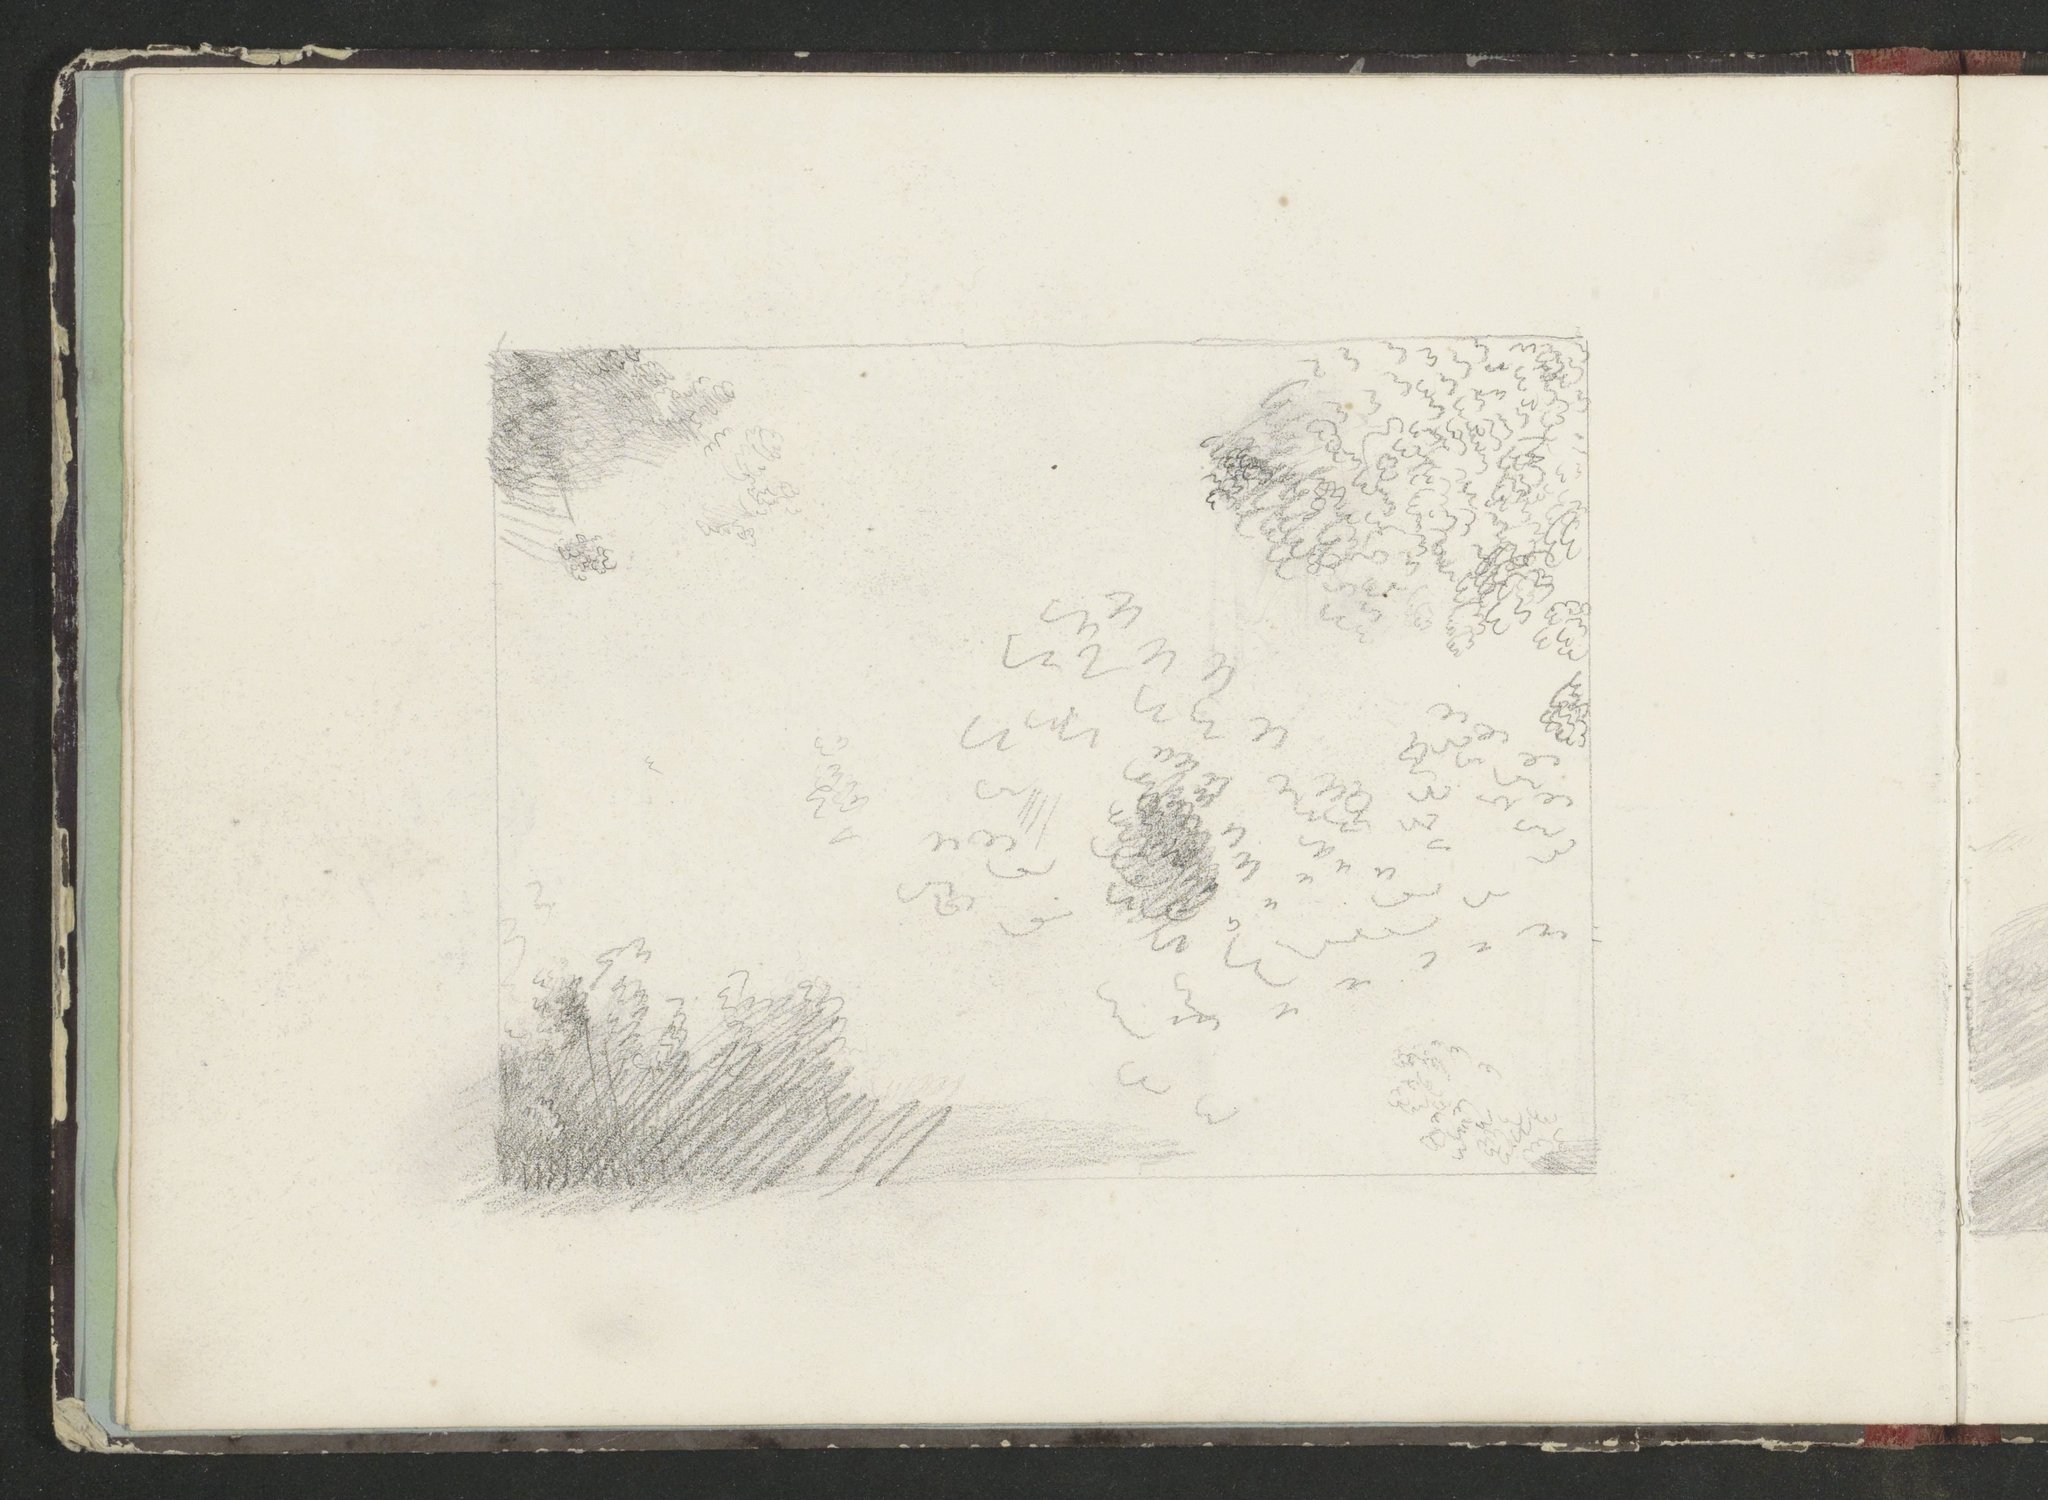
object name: sketchbook leaf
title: Landschap met gras en gebladerte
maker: Anonymous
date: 1819-1870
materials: paper, pencil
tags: trees (+ leaf), landscapes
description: Tekening in een kader. Blad 2 verso uit een schetsboek met 39 bladen.